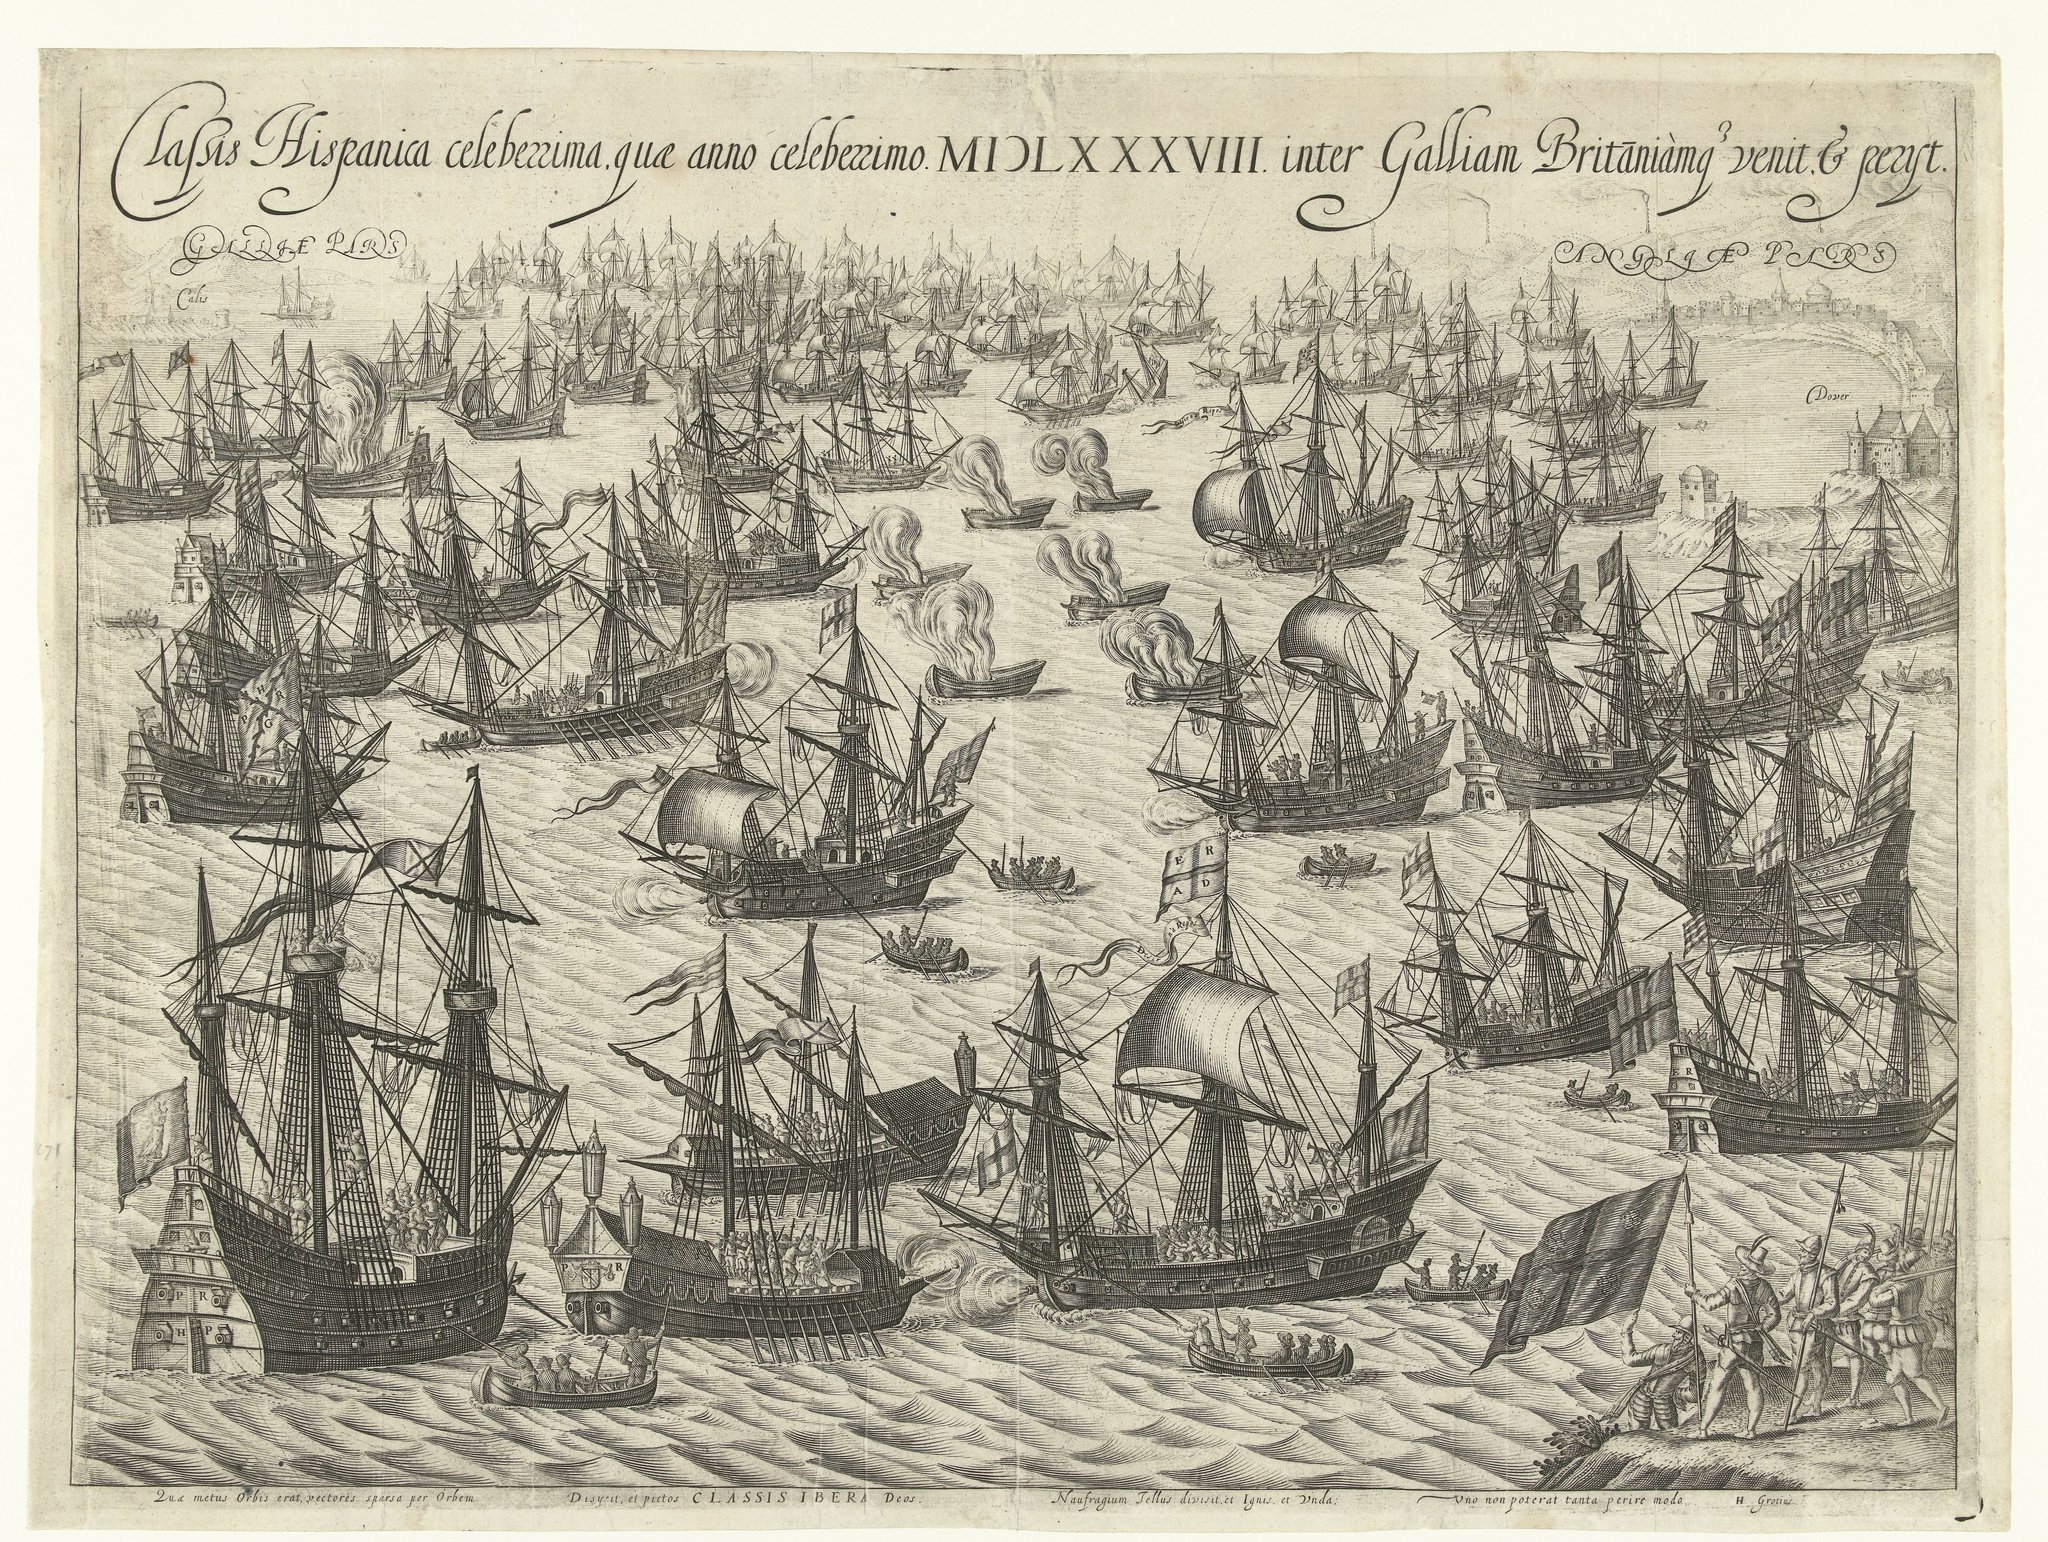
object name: history print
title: Classis Hispanica celeberrima quae anno celeberrimo MDLXXXVIII inter Galliam Britan[n]iamq. venit & peryt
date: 1593-1645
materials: paper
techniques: engraving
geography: northern netherlands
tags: battle (+ naval force), english channel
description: Ondergang van de Spaanse Armada of Onoverwinnelijke vloot, tussen 31 juli en 12 augustus 1588. Spaanse schepen in het Kanaal tussen Dover en Calais in gevecht met Engelse schepen. In het midden enkele branders, rechts op de voorgrond Engelse soldaten aan de Engelse kust. Bovenin de plaat de titel, in het onderschrift 4 regels in het Latijn.